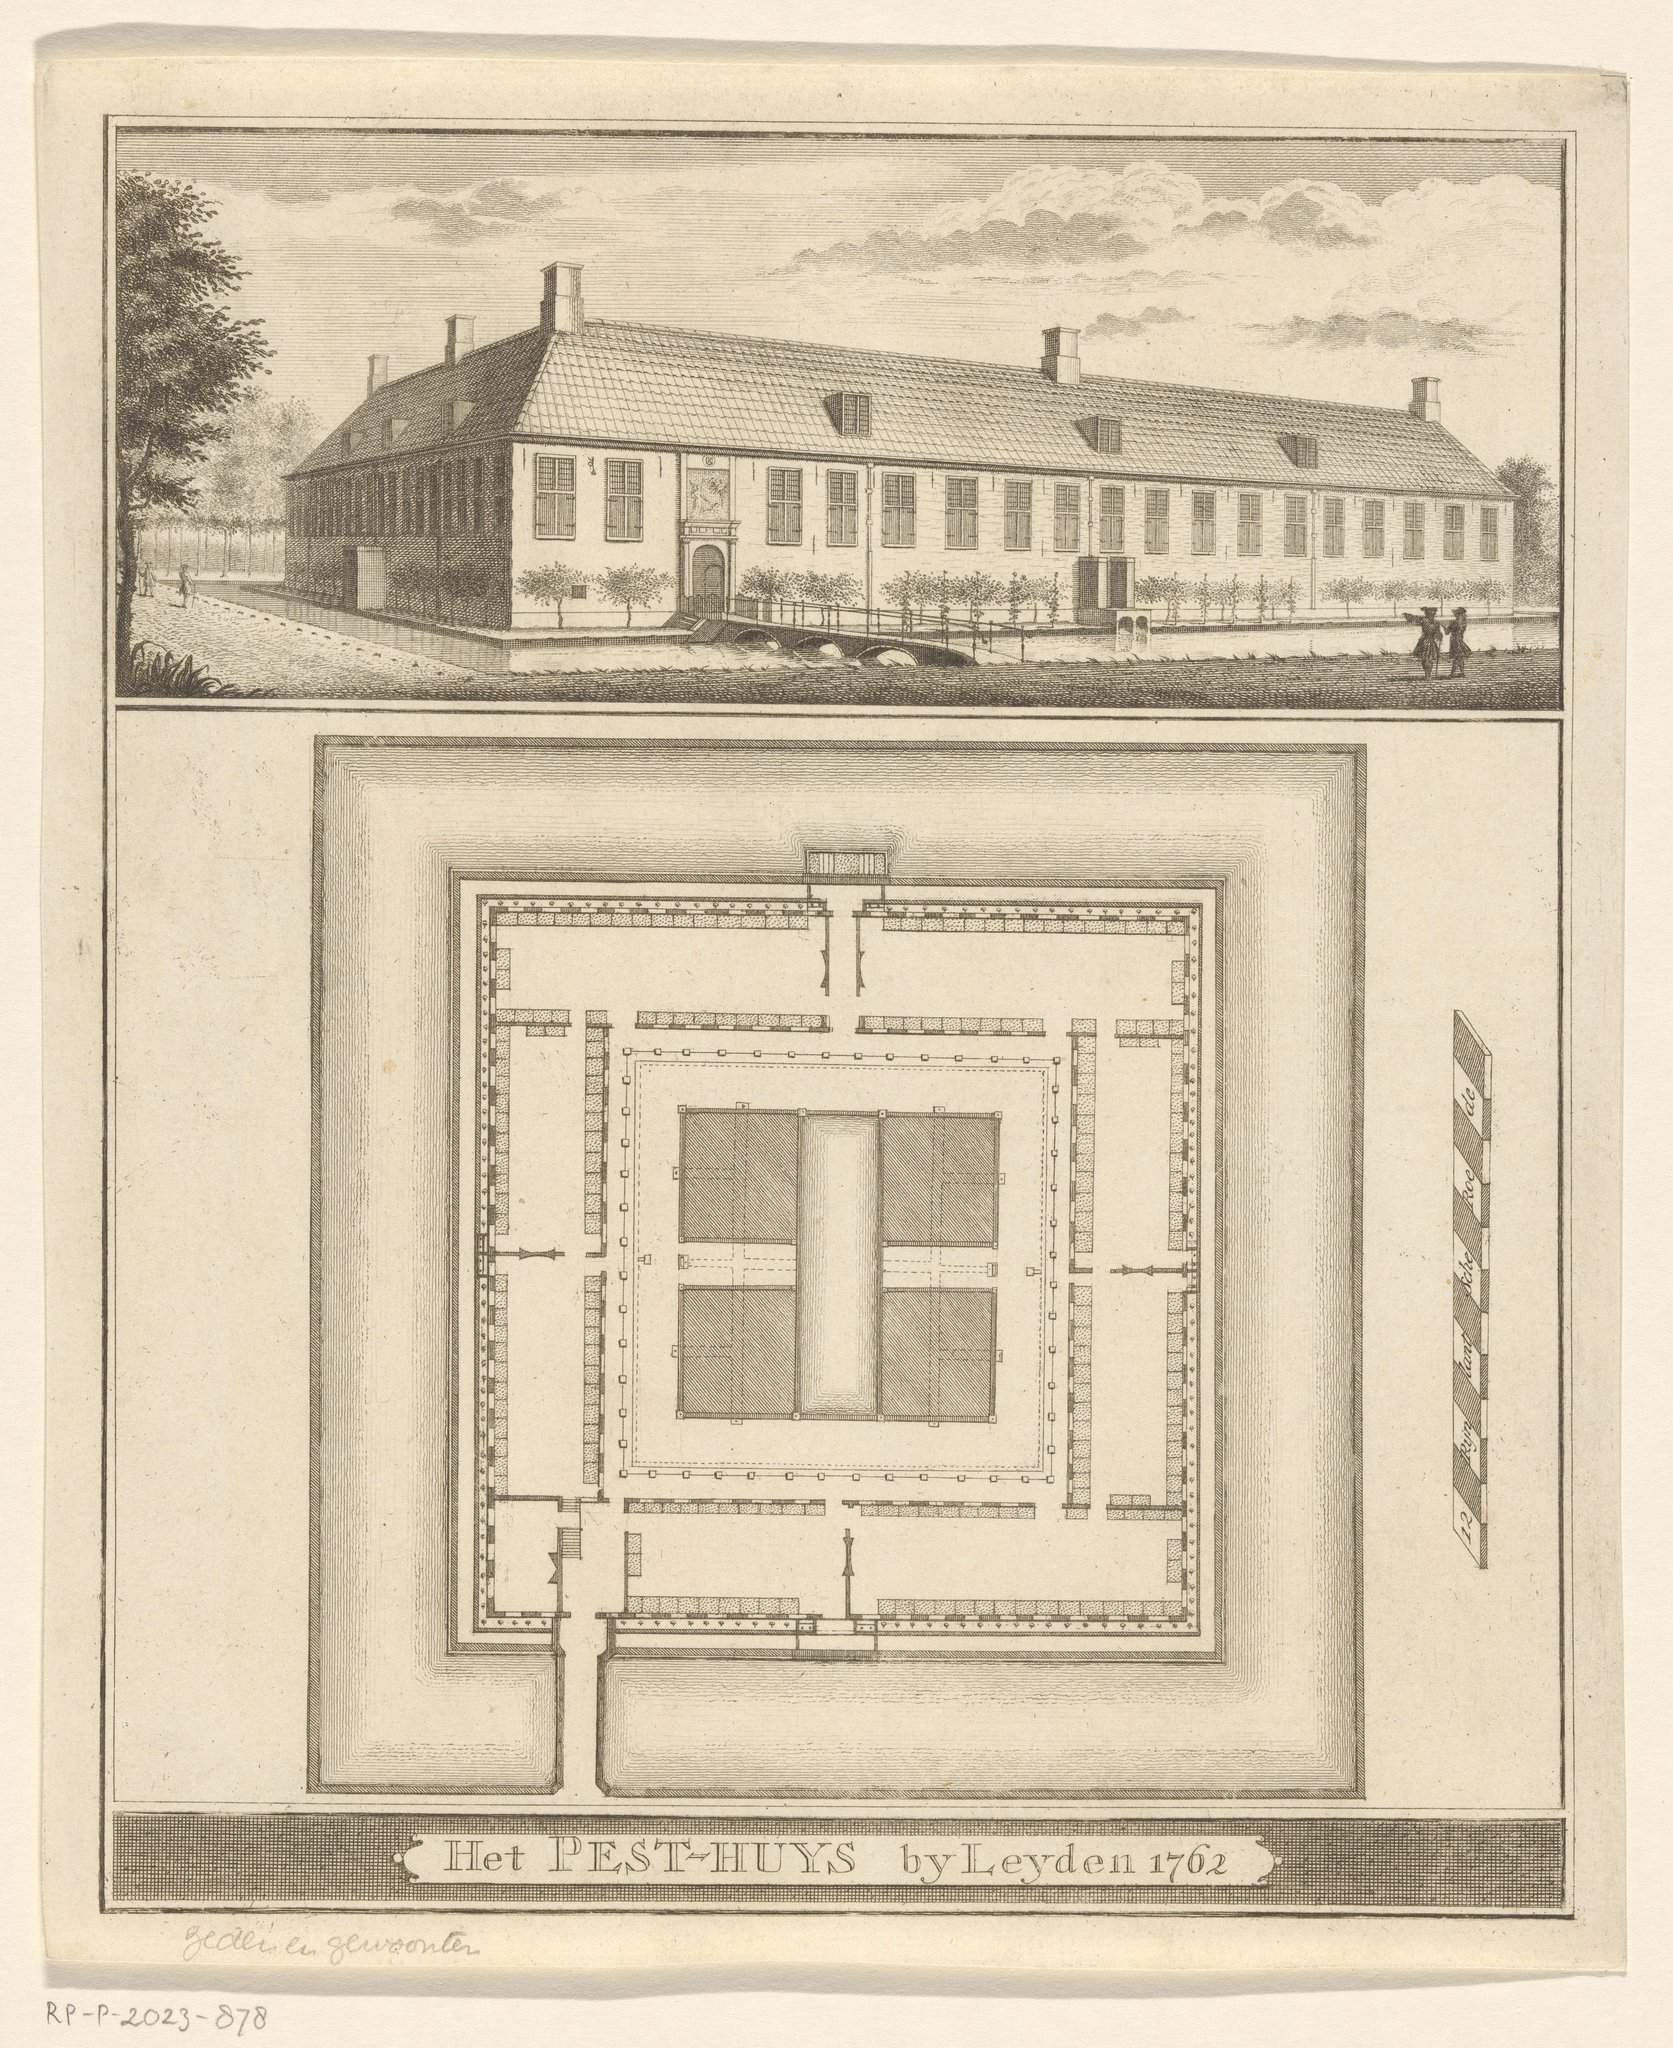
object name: area plan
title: Het Pest-Huys by Leyden 1762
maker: Anonymous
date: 1762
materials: paper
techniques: engraving, etching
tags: hospital, plan ~ architecture, leiden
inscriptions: collector's mark: Lugt 2228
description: Prent ook gebruikt in: Mieris, Frans van (II). Beschryving der stad Leyden, haare gelegenheid, oorsprong, vergrootinge, oude en hedendaagsche gedaante (…). 3 delen. Leiden: weduwe Abraham Honkoop, Cornelis van Hoogeveen junior e.a., 1762-1784, dl. 1 (1762), tussen p. 230 en 231.